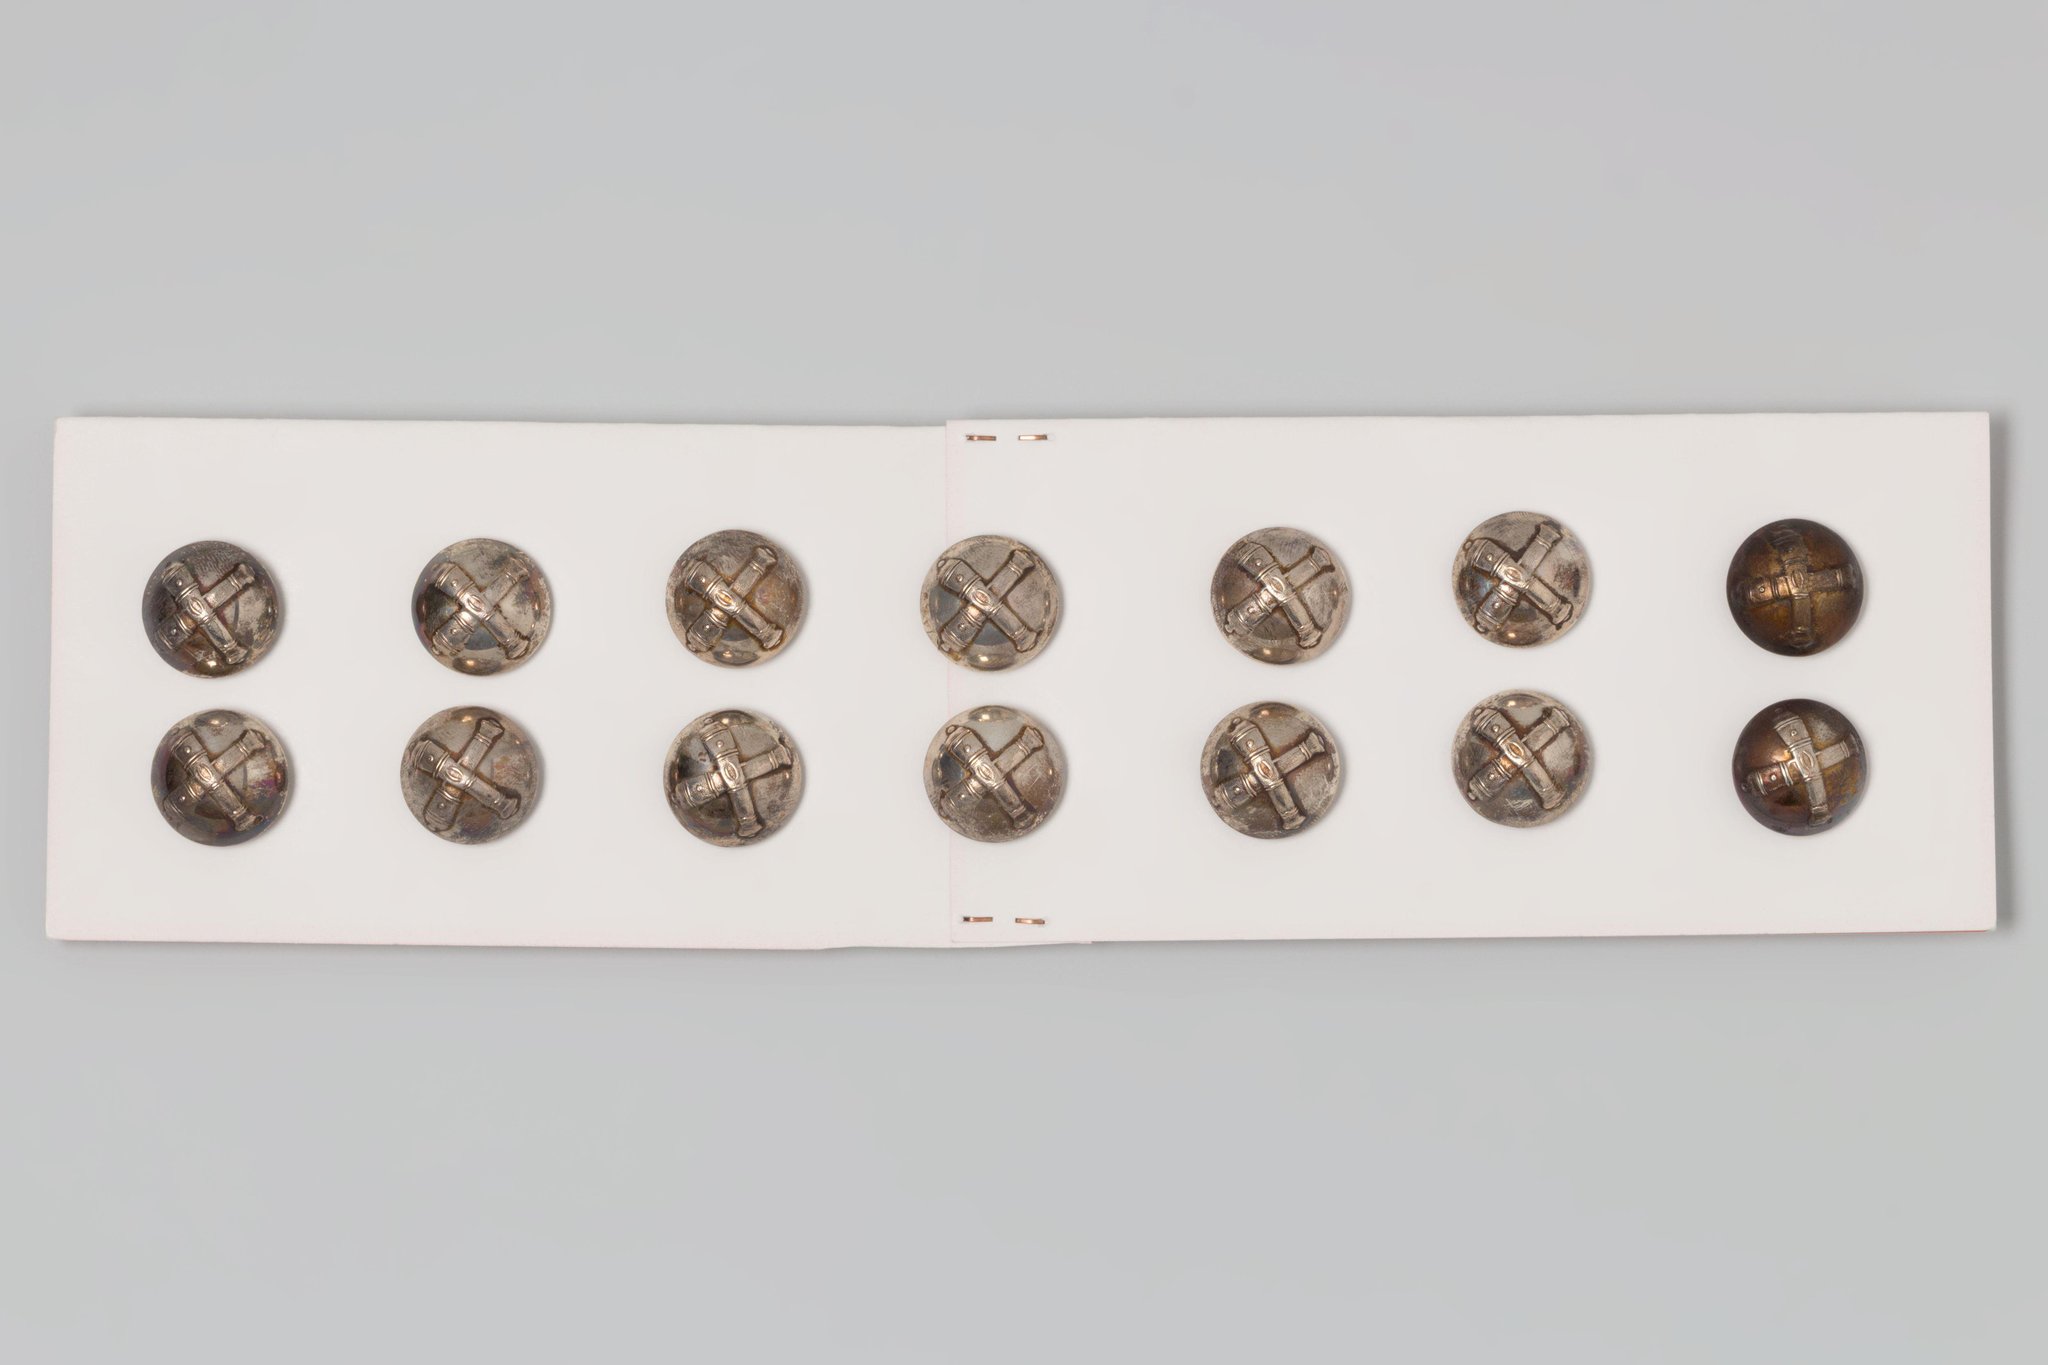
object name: uniform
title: Bolvormige knoop van verzilverd koper, waarop twee gekruiste kanonnen in reliëf; onderdeel van een artillerie-uniform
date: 1885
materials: copper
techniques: silvering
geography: the hague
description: Geborgen in een doos bij een sjerp; notitie in doos: "W. Six 1859-1928/14 knoopen schutterij uniform/1885".